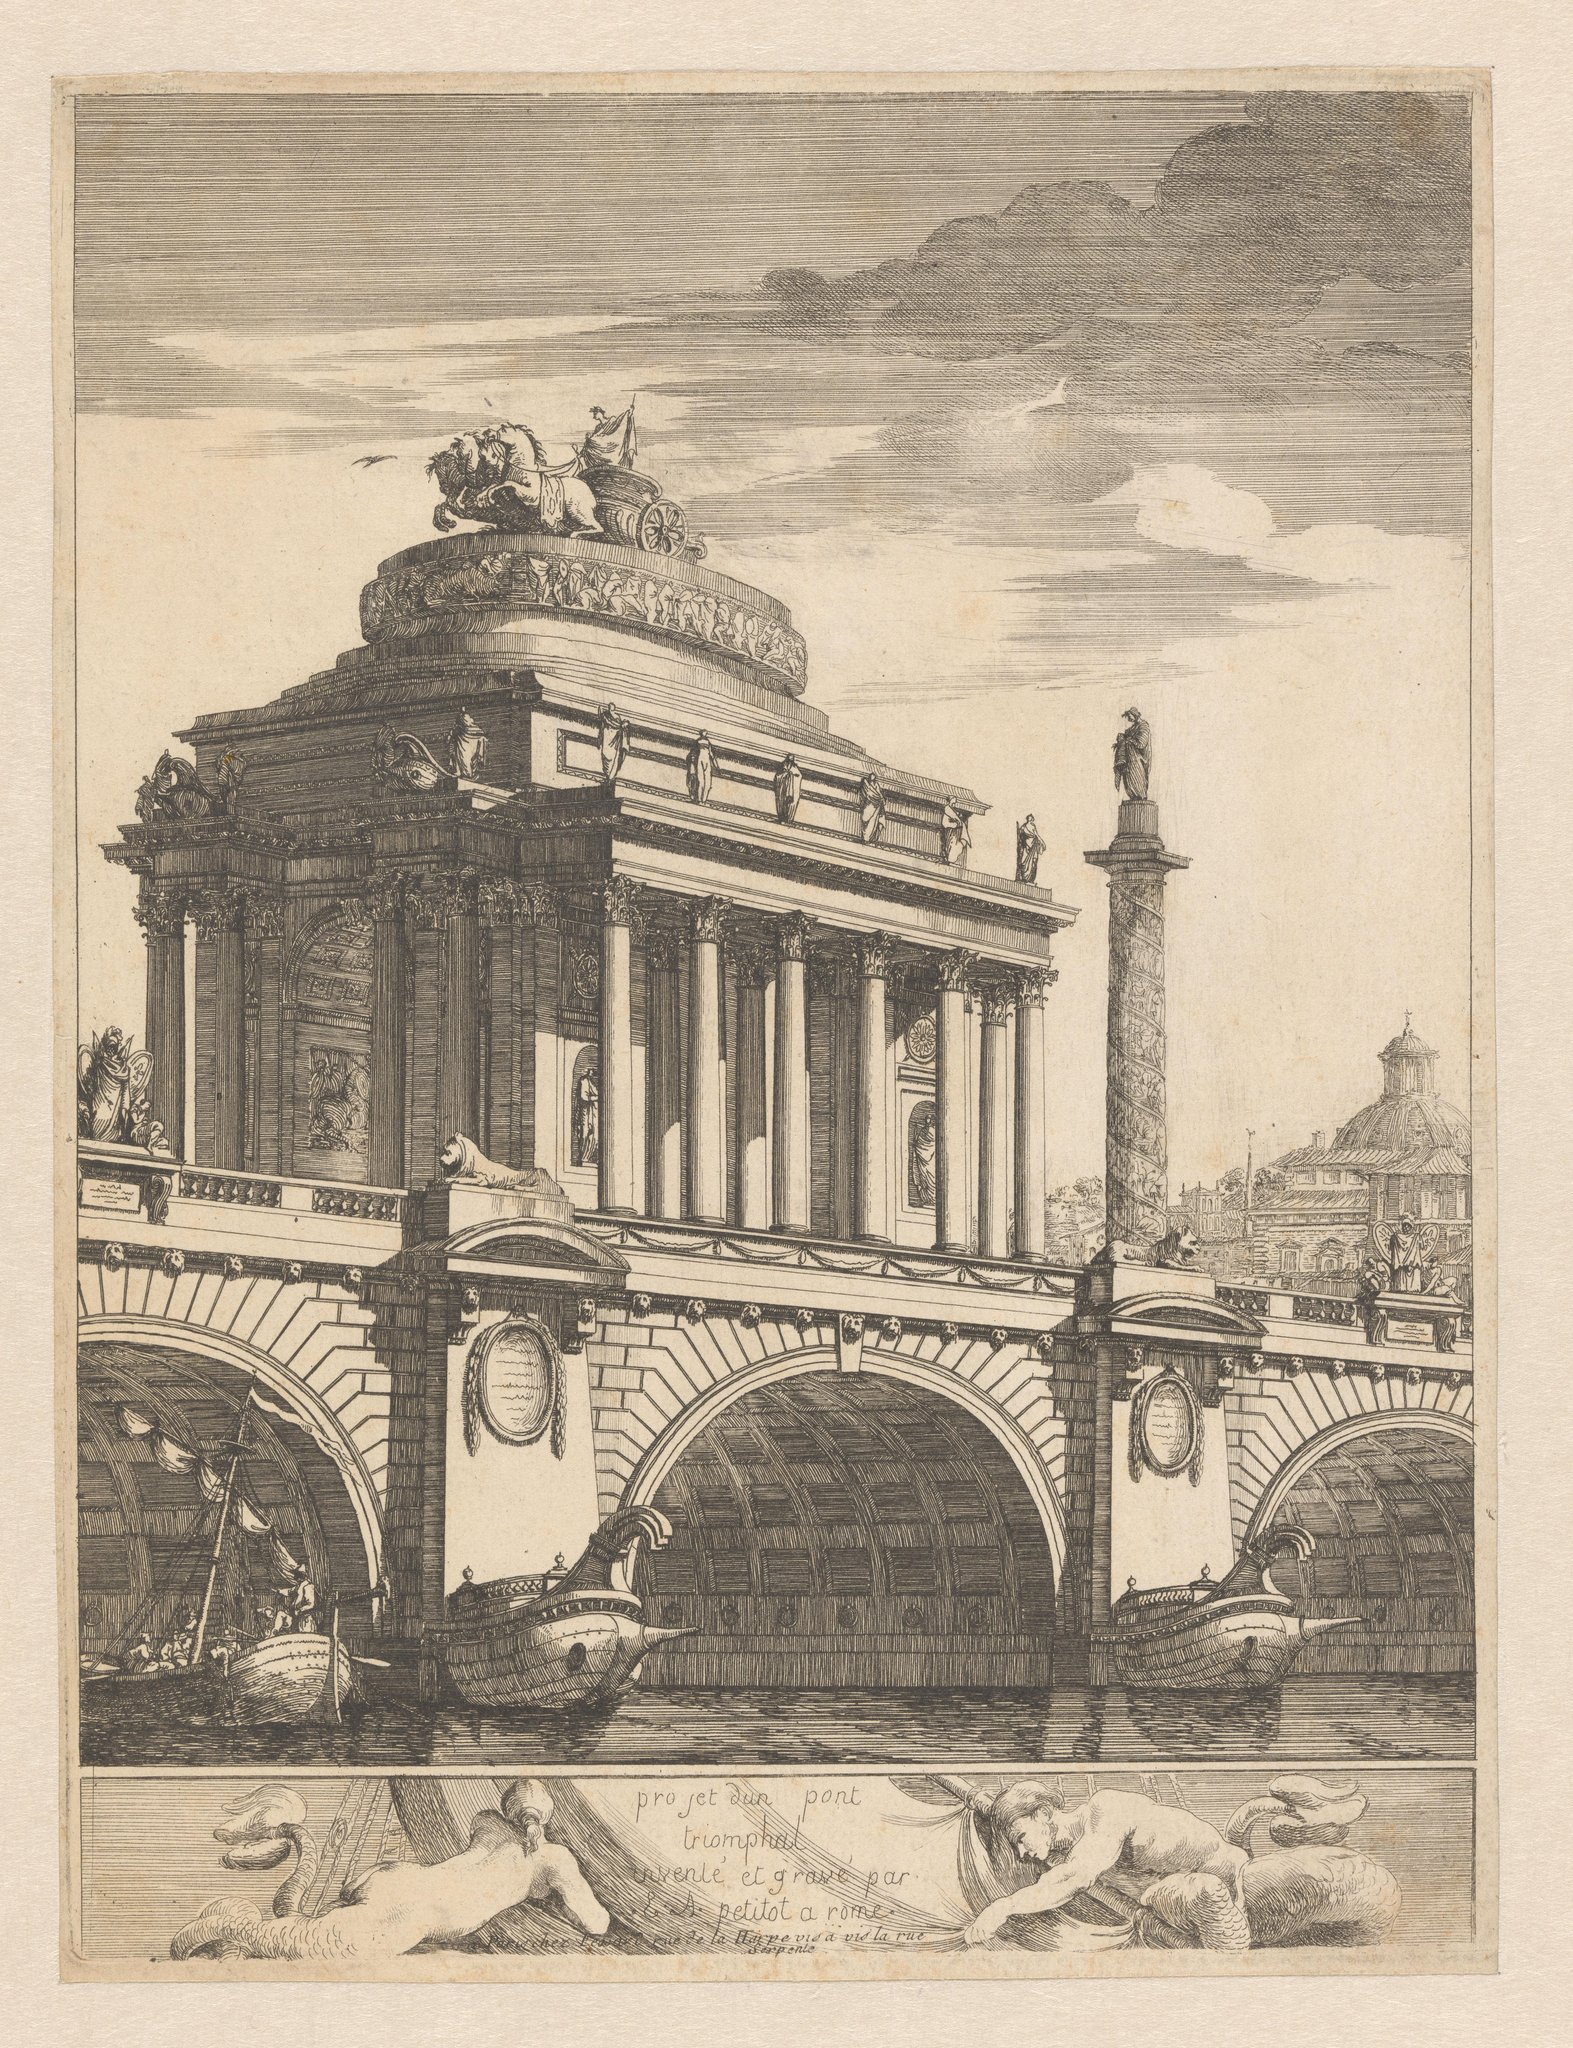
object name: print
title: Ontwerp voor een grote poort op een brug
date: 1749-1760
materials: ink, paper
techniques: etching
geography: rome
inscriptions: number, collector's mark